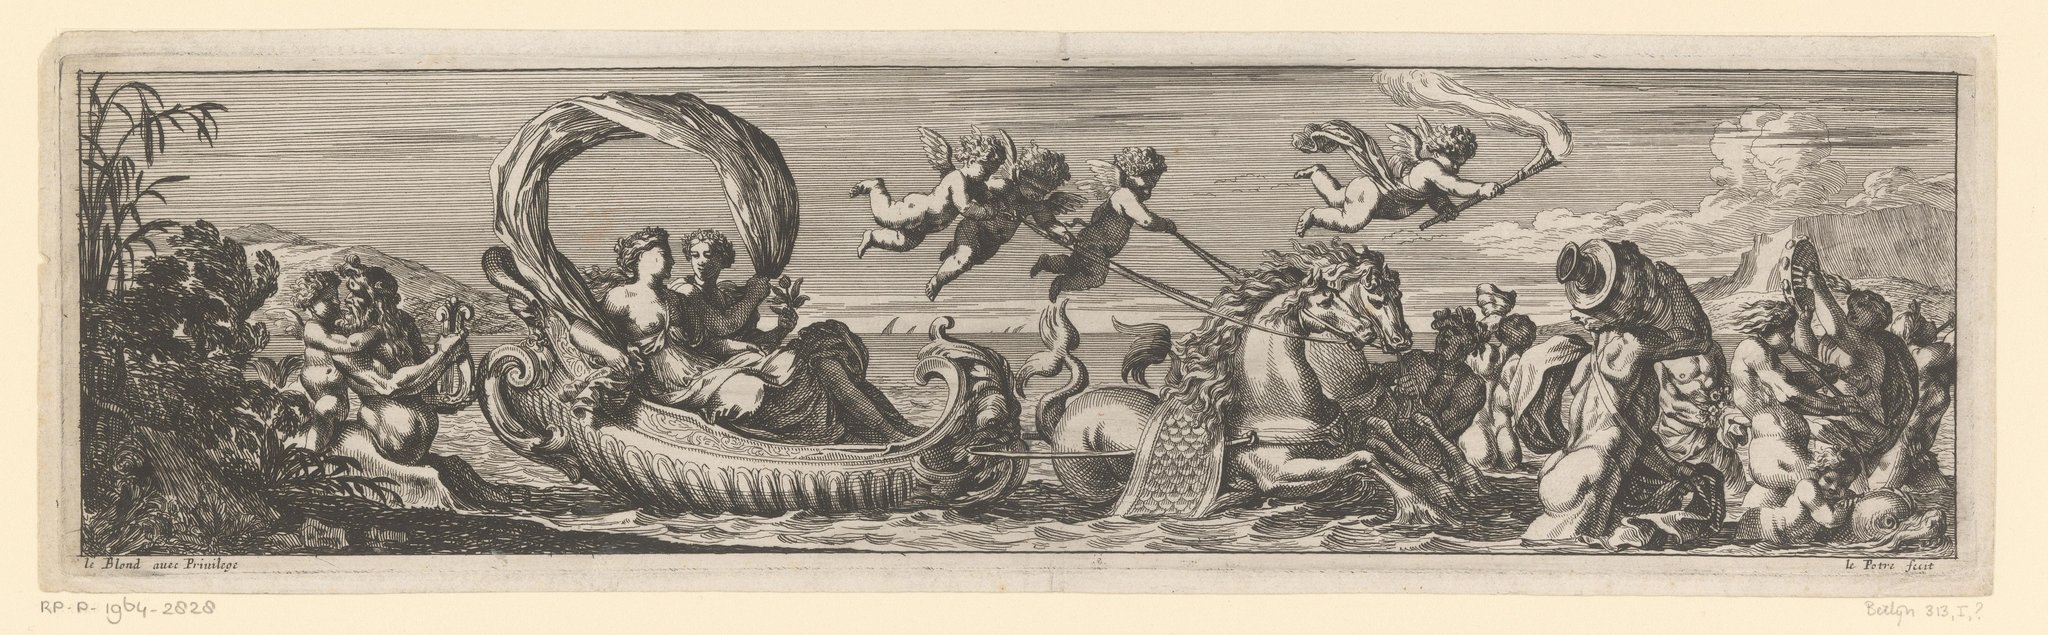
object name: ornament print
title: Friezen met zeegoden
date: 1628-1682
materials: paper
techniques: etching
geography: paris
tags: triumph of amphitrite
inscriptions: collector's mark: Lugt 2760, collector's mark: Lugt 2228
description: Fries met de triomf van een zeegodin, mogelijk Amphitrite. De godin zit samen met een tweede vrouw in een wagen getrokken door twee hippocampi. Boven de hippocampi vliegen putti, waarvan één met een fakkel. Voor de wagen lopen diverse figuren met schelpen, bazuinen, een tamboerijn en een vaas.